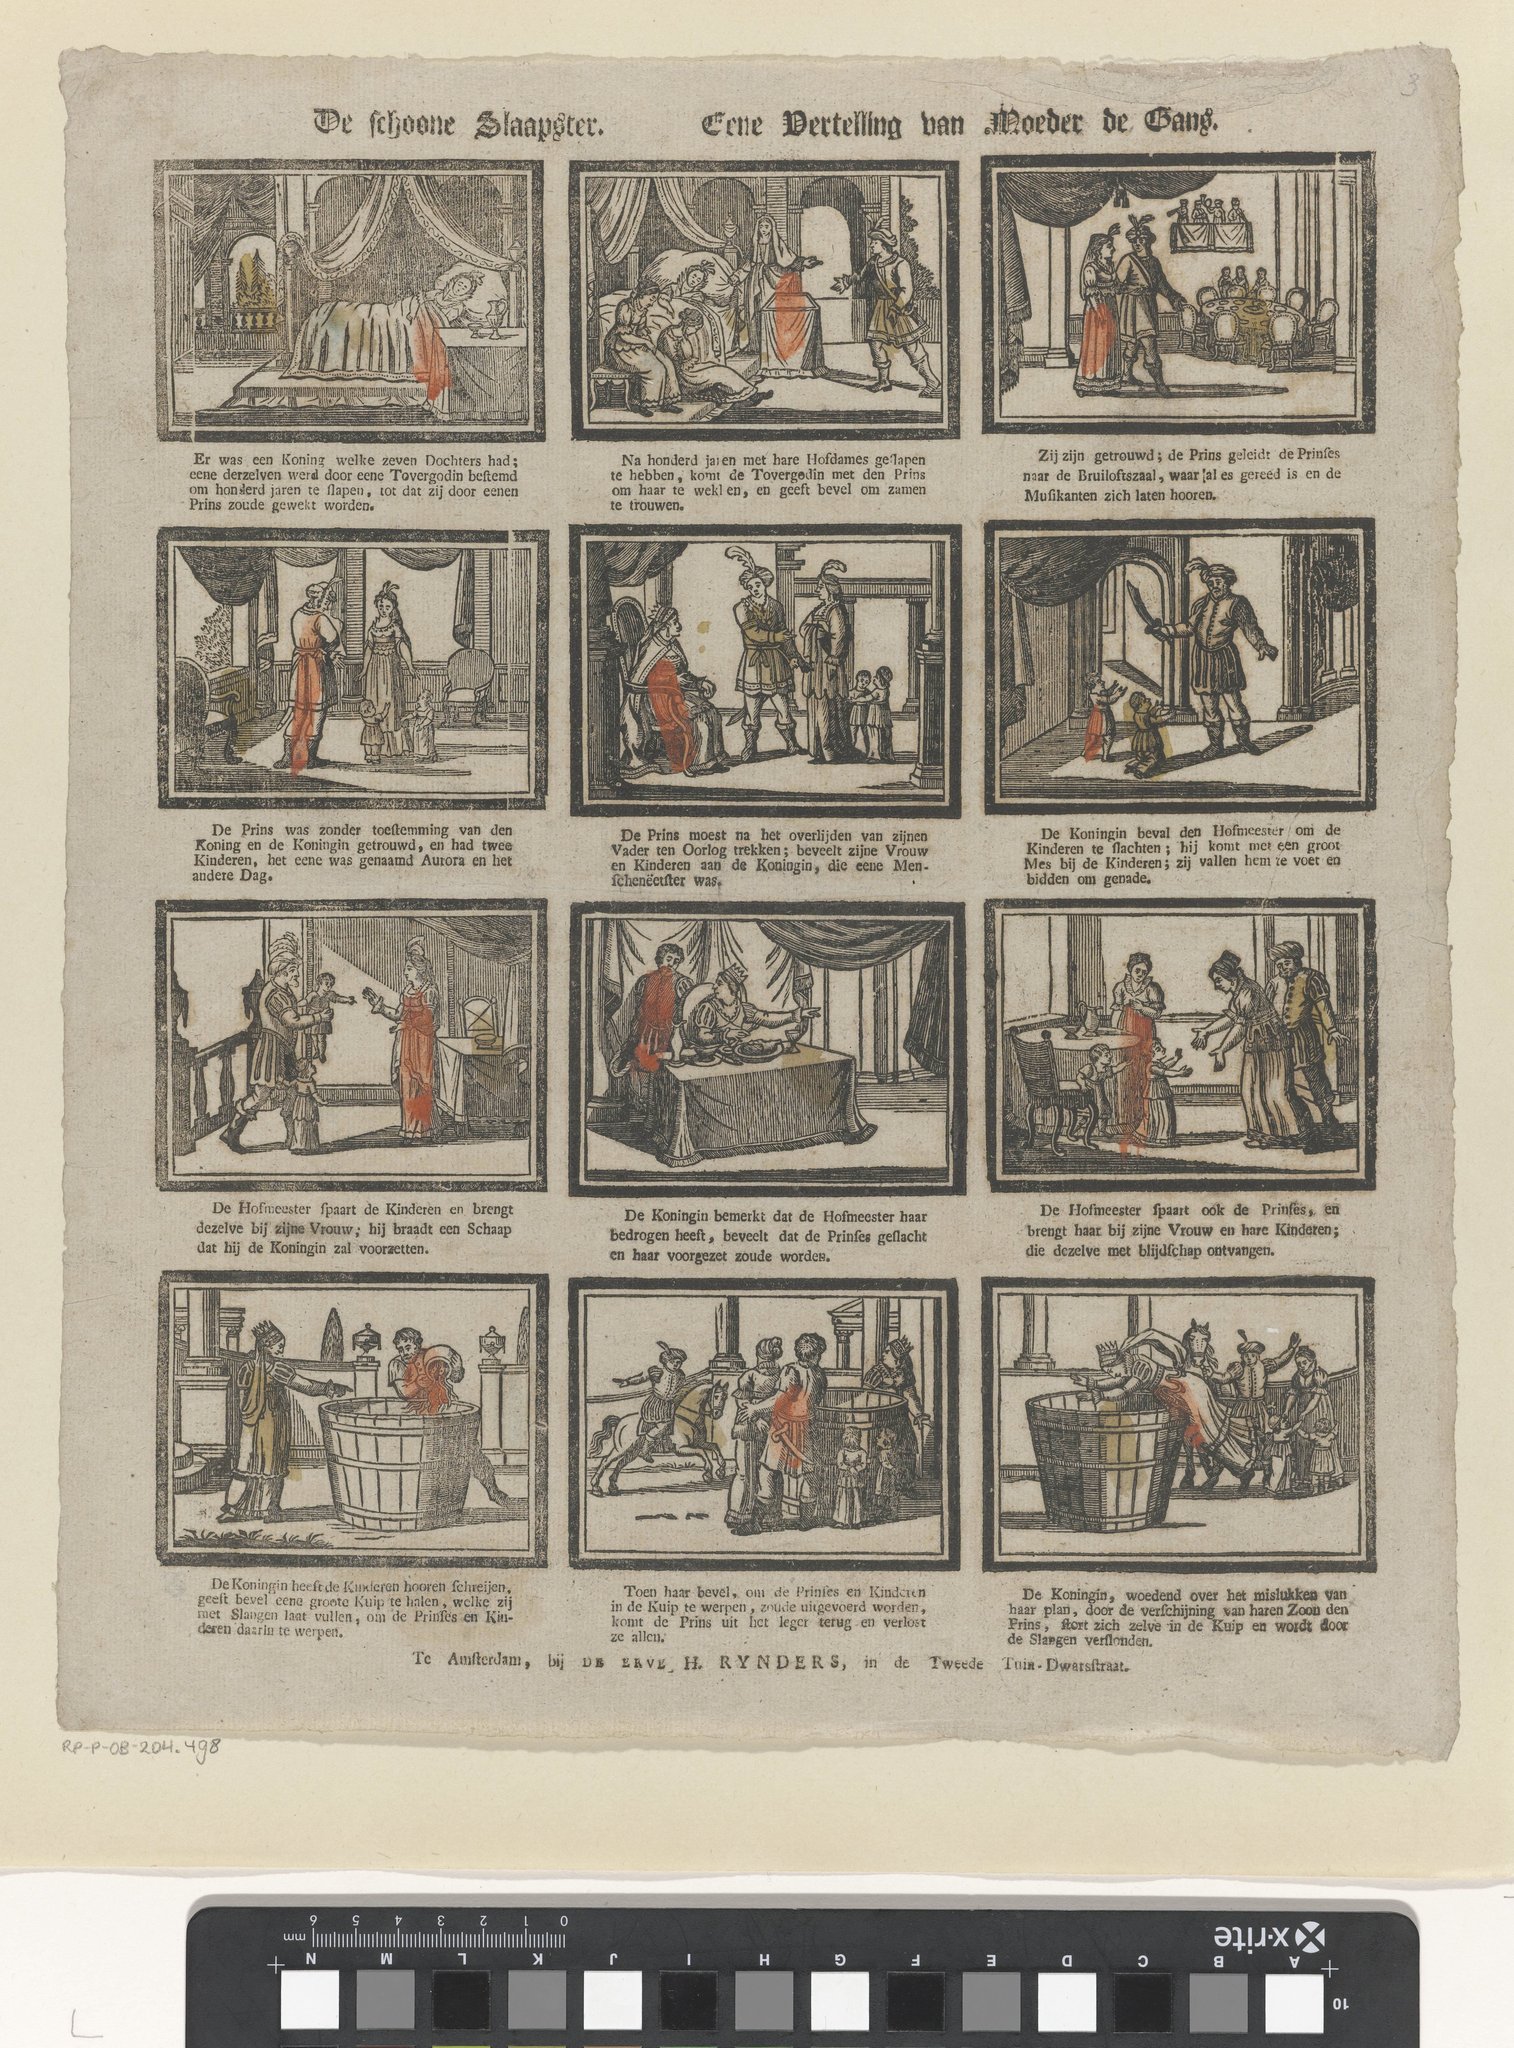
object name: popular print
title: De schoone slaapster. / Eene vertelling van Moeder de Gans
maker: Anonymous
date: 1831-1854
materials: paper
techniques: colour, letterpress printing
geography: netherlands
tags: tales and fairy tales: sleeping beauty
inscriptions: collector's mark: Lugt 2760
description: Blad met 12 voorstellingen uit het sprookje van de Schone Slaapster en haar gemene schoonmoeder de koningin. De koningin probeert de prinses en haar kinderen te vermoorden. Onder elke voorstelling een onderschrift.